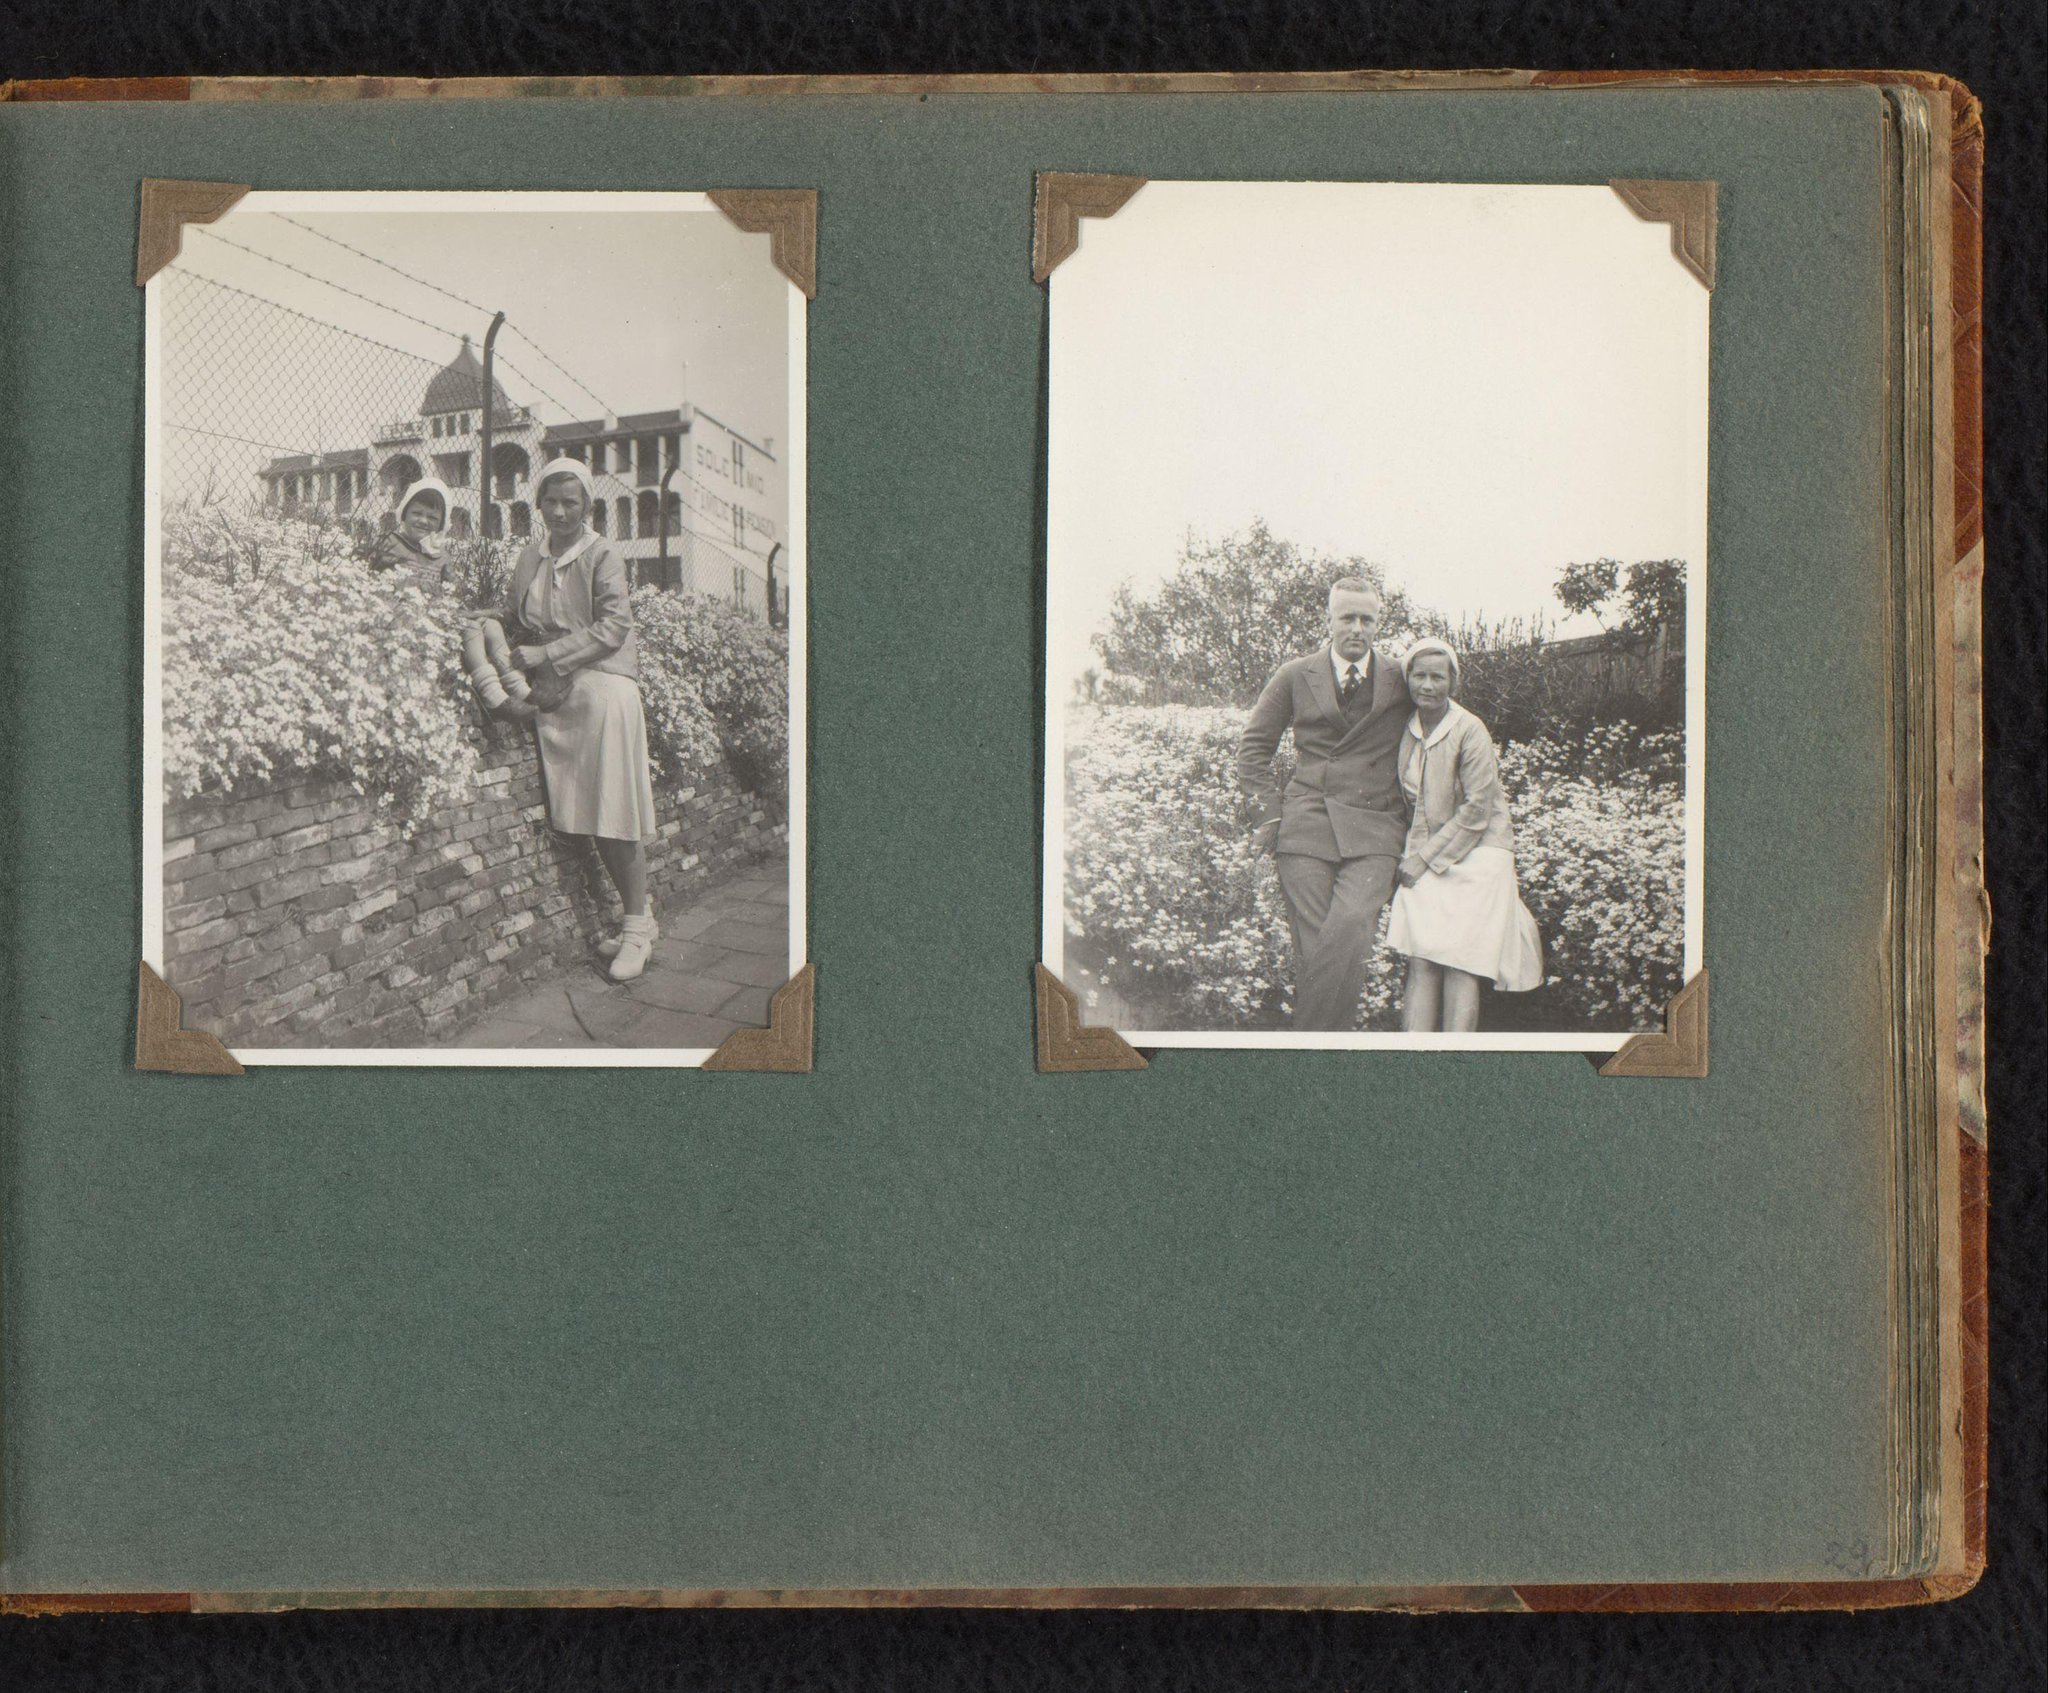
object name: photograph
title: Twee foto's van familie Furnée-Van den Berg in Noordwijk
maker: Anonymous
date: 1920-1930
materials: paper, cardboard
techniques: gelatin silver print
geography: noordwijk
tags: beach (as place of recreation), child, historical persons, family life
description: Deze foto's maken deel uit van een album.